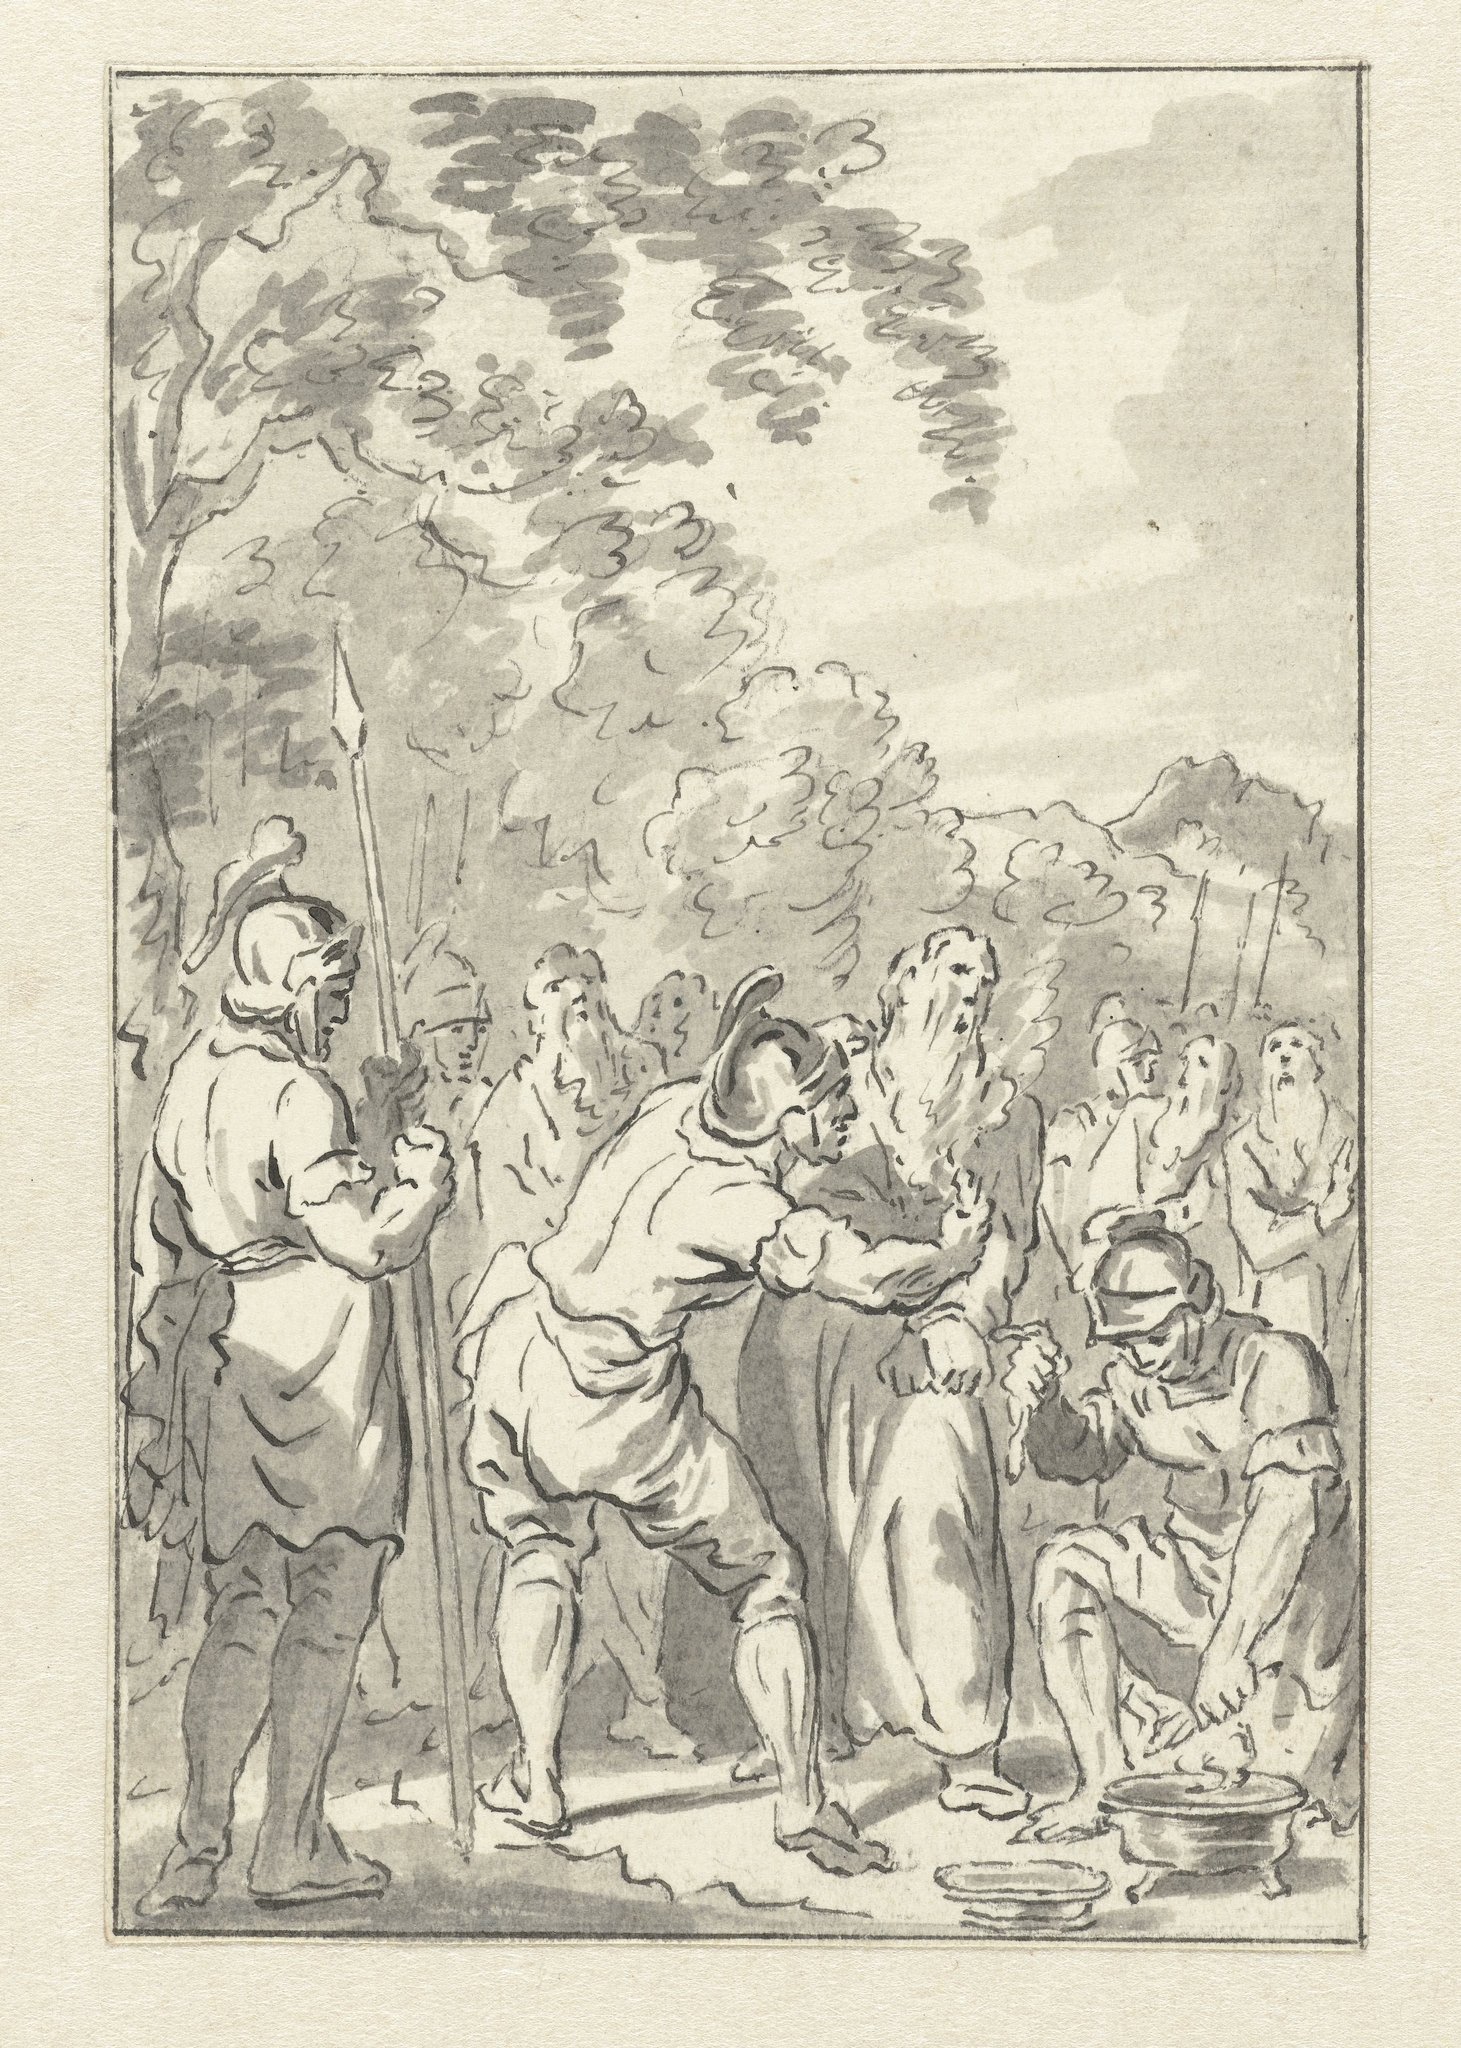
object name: drawing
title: Mishandeling der Joden in Tracië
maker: jacobus buys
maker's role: draughtsman, print maker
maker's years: 1724-1801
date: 1734-1801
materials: chalk, ink, paper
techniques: brush, pen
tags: outbreaks of violence ~ anti-semitism, torture